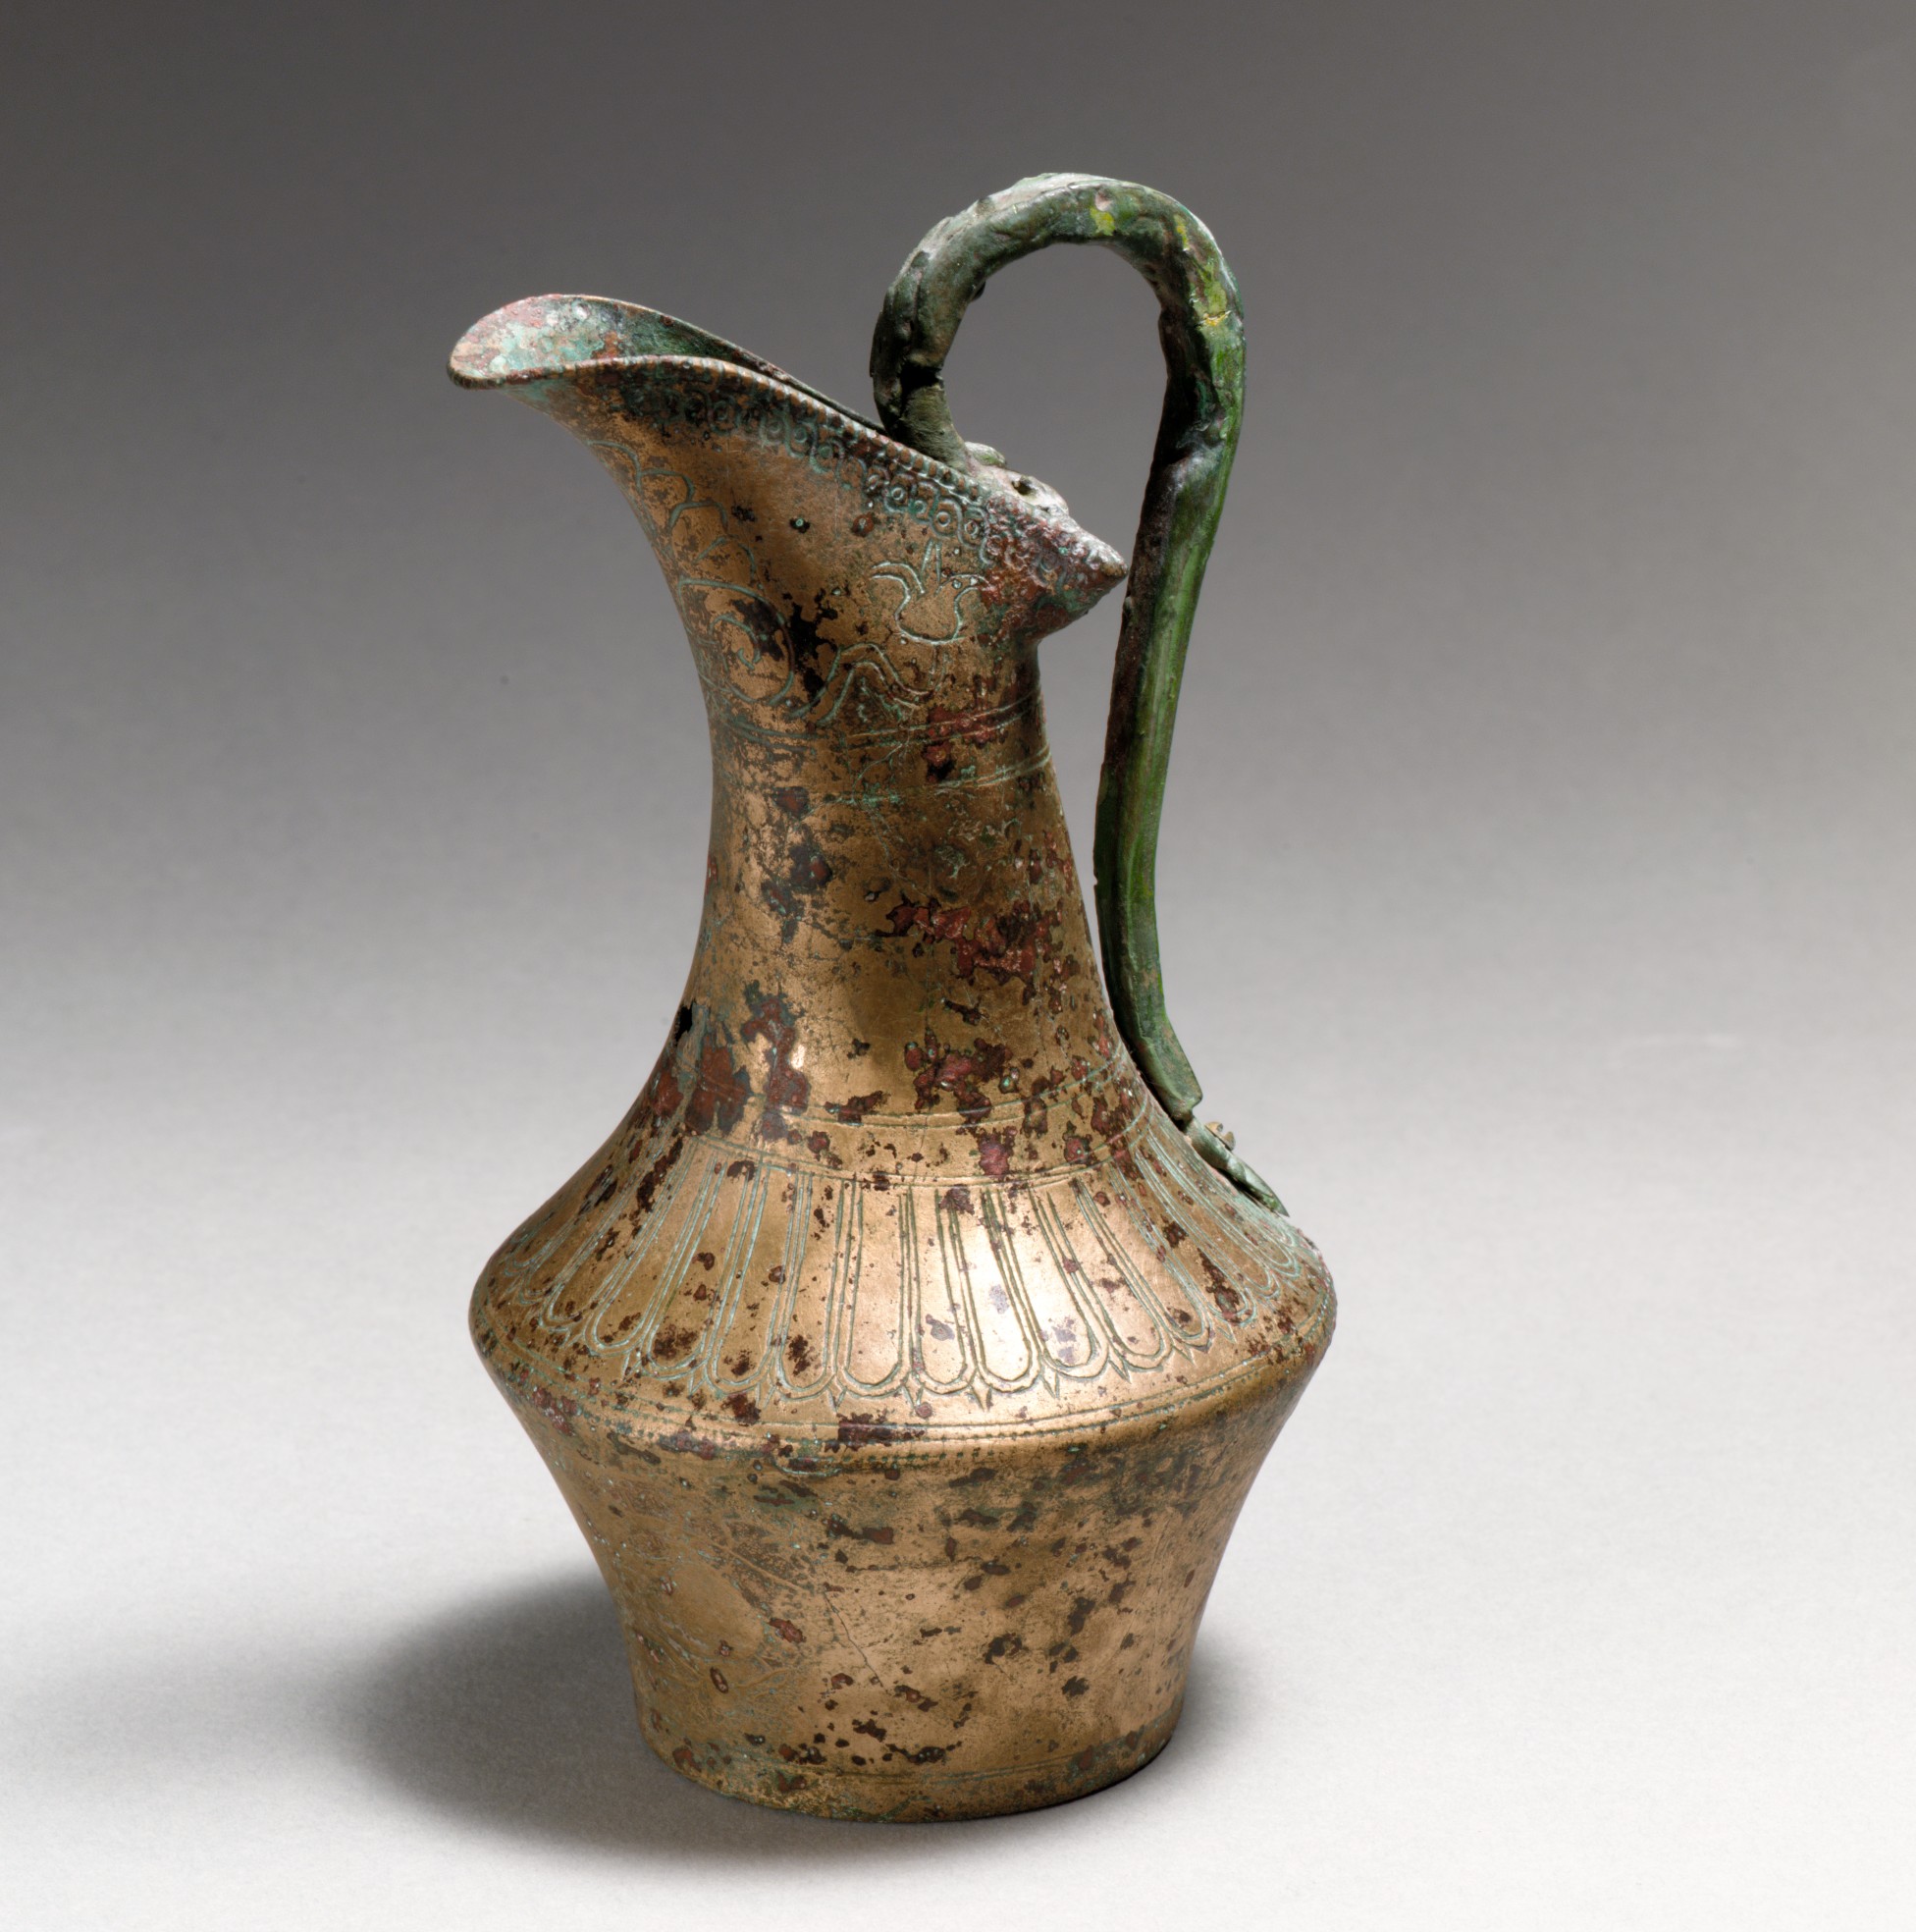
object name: oinochoe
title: Bronze beaked oinochoe (jug)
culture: etruscan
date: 534-501 BCE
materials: bronze